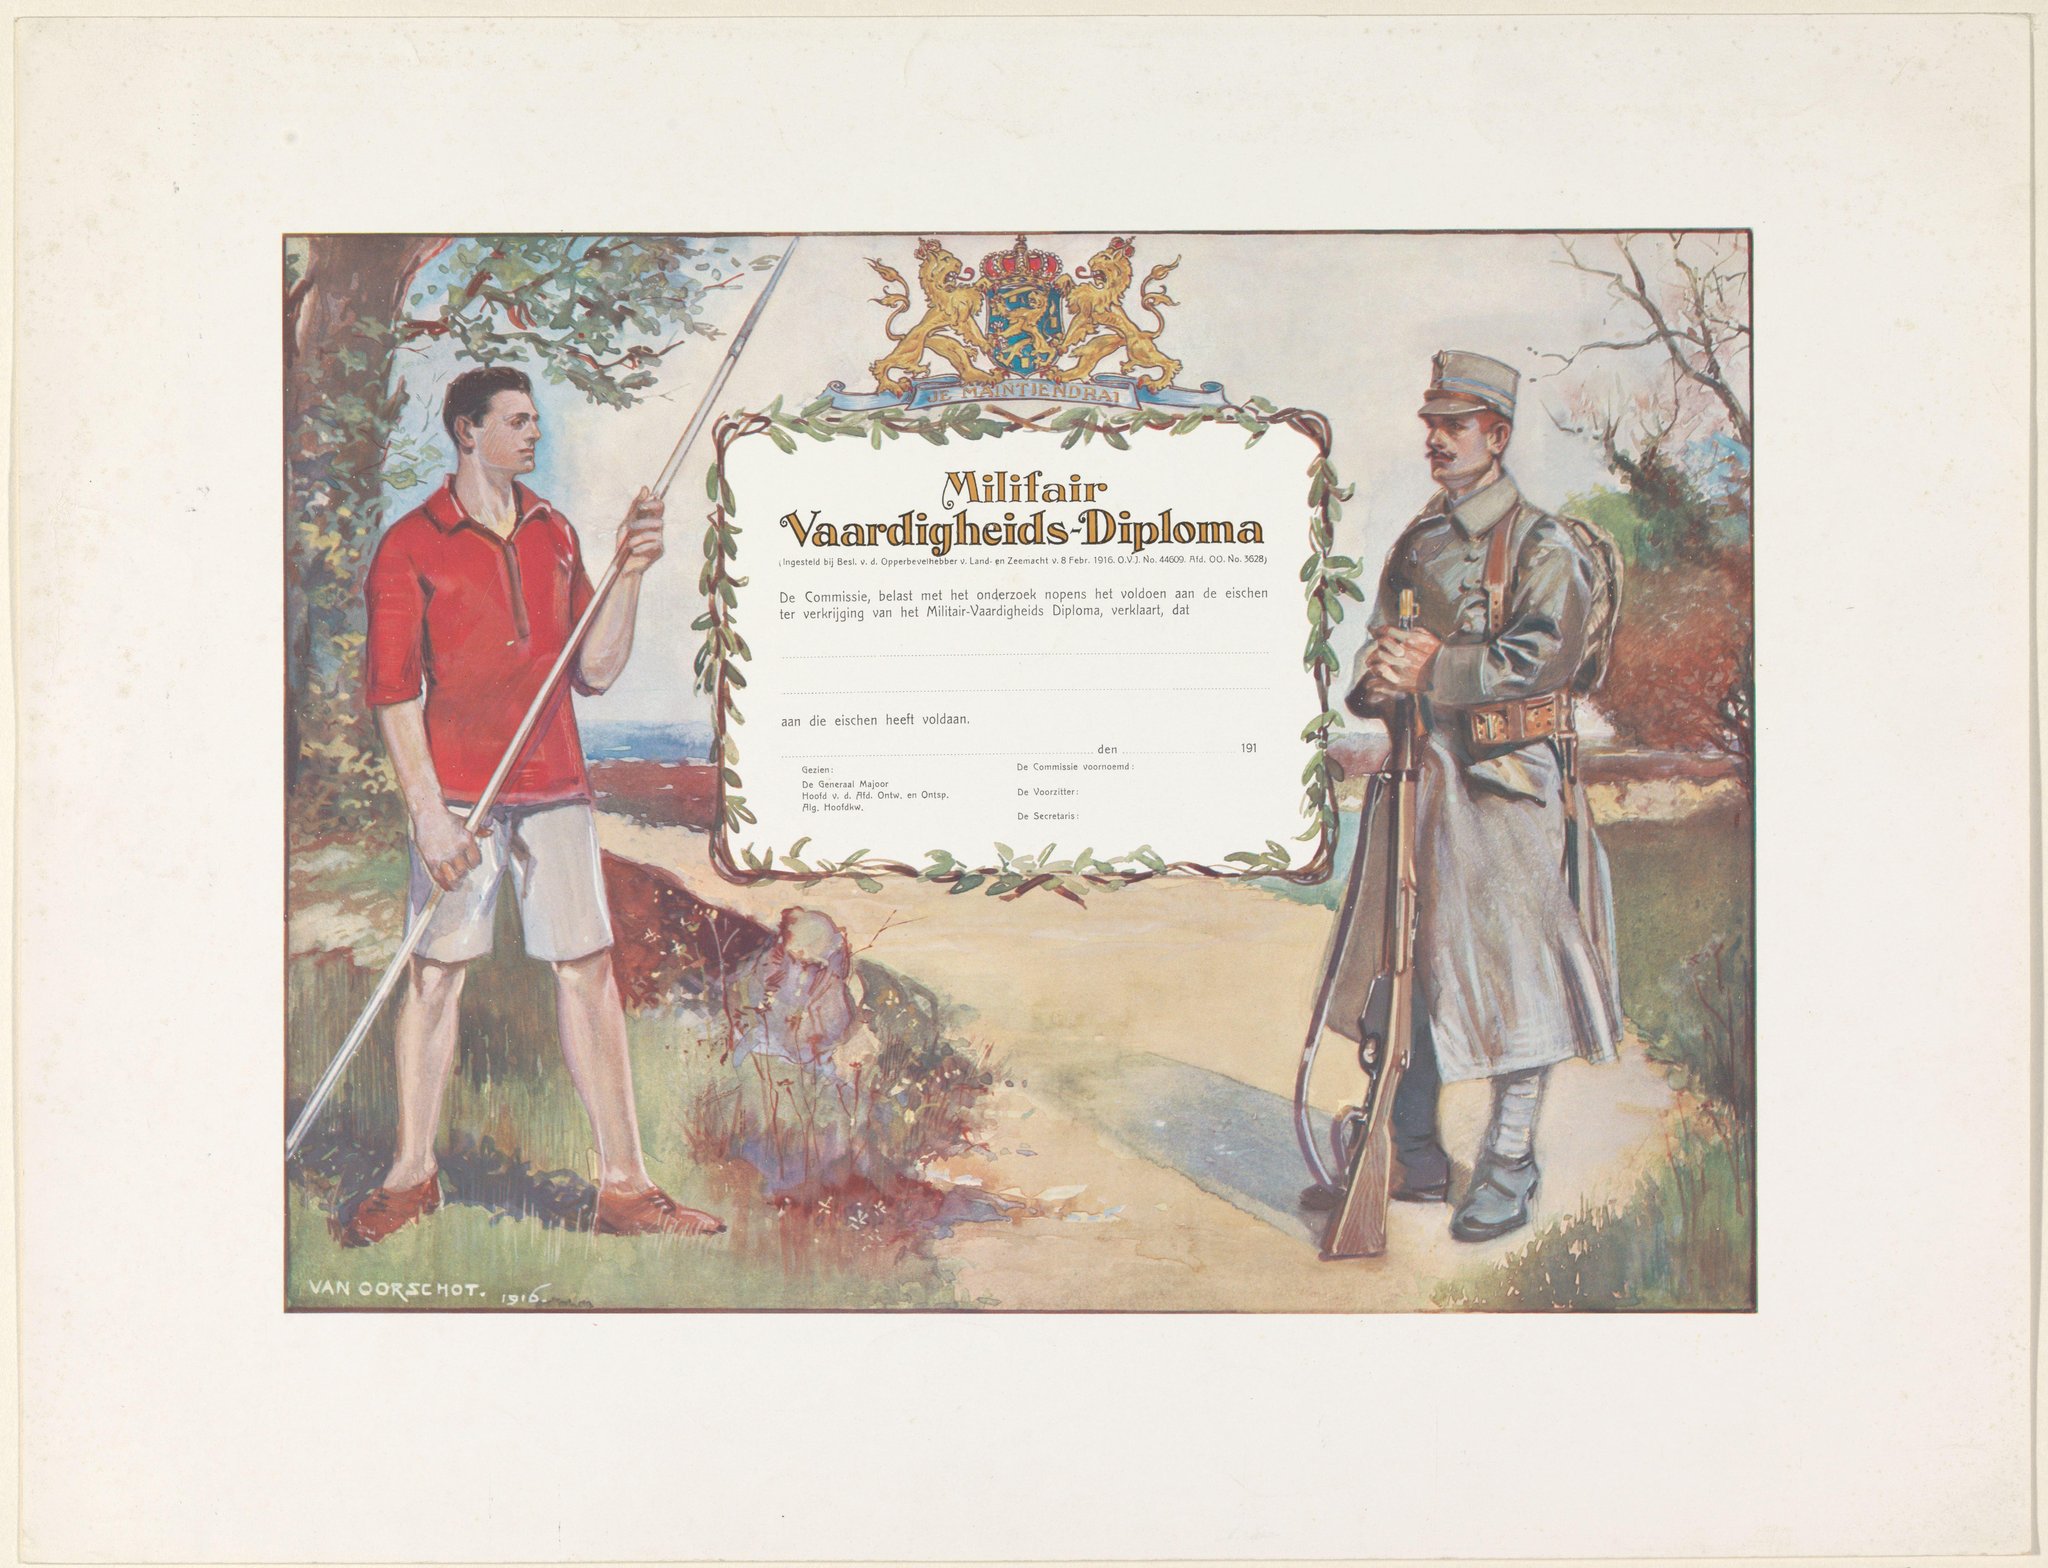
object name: certificate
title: Militair Vaardigheidsdiploma, 1916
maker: johan willem van oorschot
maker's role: draughtsman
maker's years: 1875-1952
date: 1916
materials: paper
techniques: color autotype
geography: netherlands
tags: military honours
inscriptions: collector's mark: Lugt 2228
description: Militair Vaardigheidsdiploma, ingesteld door de opperbevelhebber van Land- en Zeemacht, 8 februari 1916. Oningevuld. links een burger in sportkleding met een speer in de hand, rechts een militair in uniform.